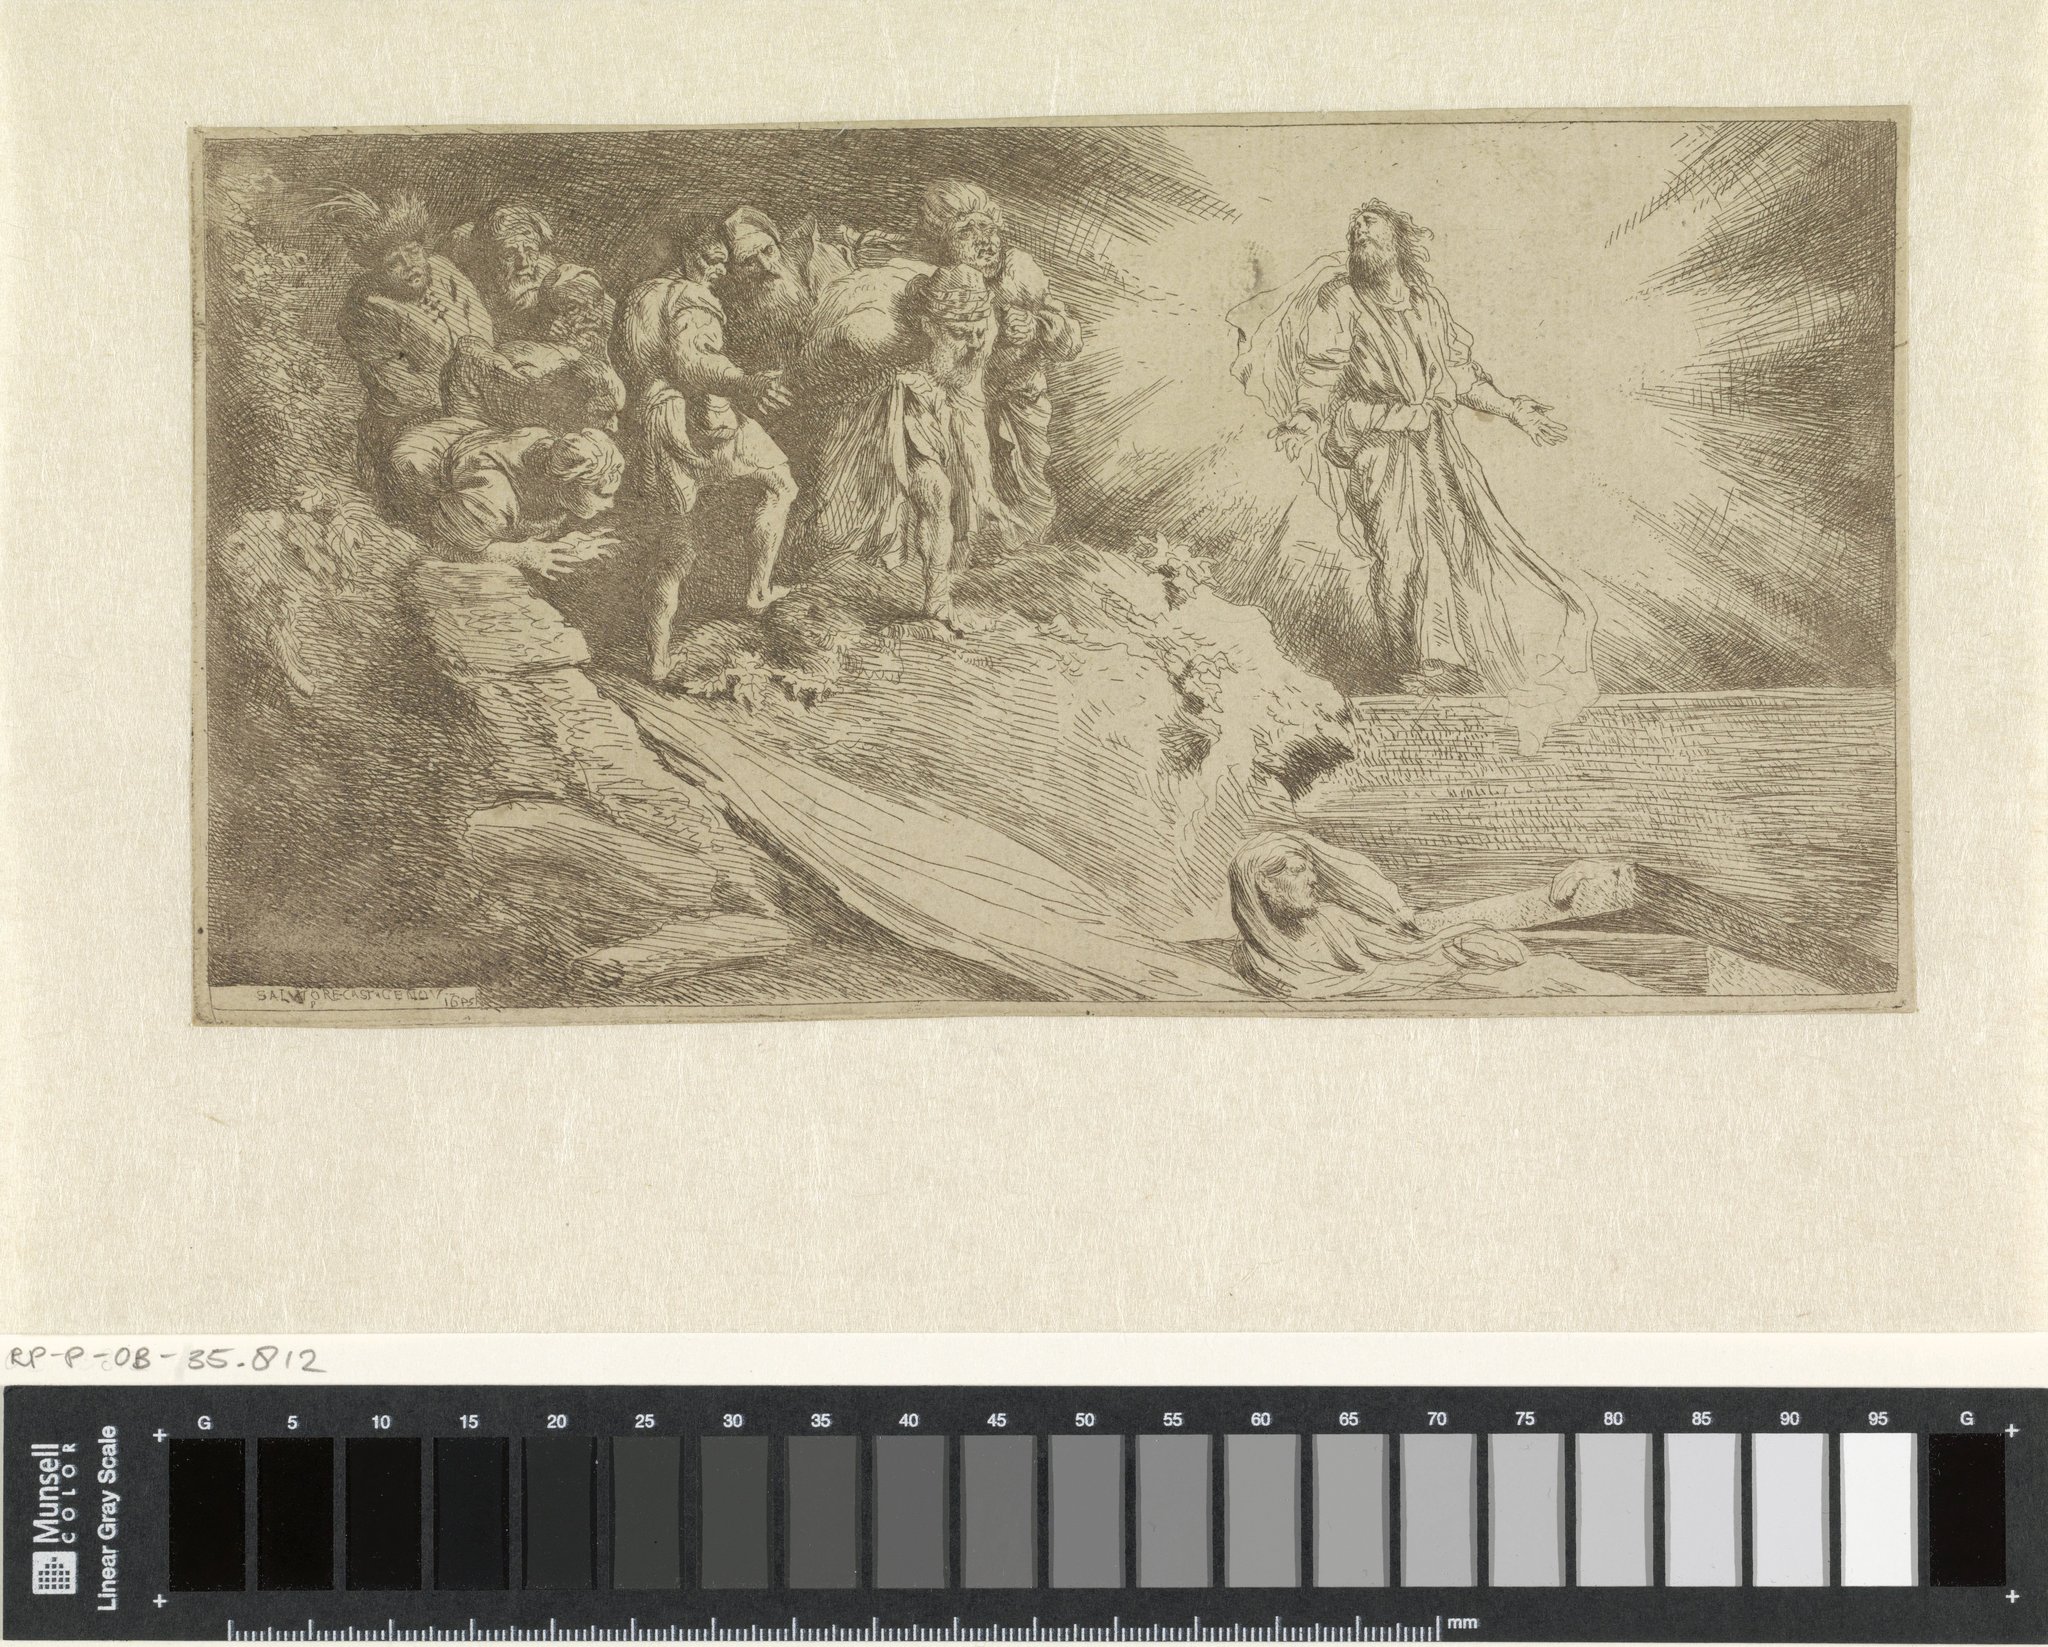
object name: print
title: Opwekking van Lazarus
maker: salvatore castiglione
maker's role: print maker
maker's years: 1620-1696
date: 1645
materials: paper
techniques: etching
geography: italy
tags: the raising of lazarus ('lazarus, come out')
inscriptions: date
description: Christus wekt Lazarus op uit de dood. Lazarus komt omhoog uit zijn graf. Een groep toeschouwers reageert verbaasd en verwonderd.